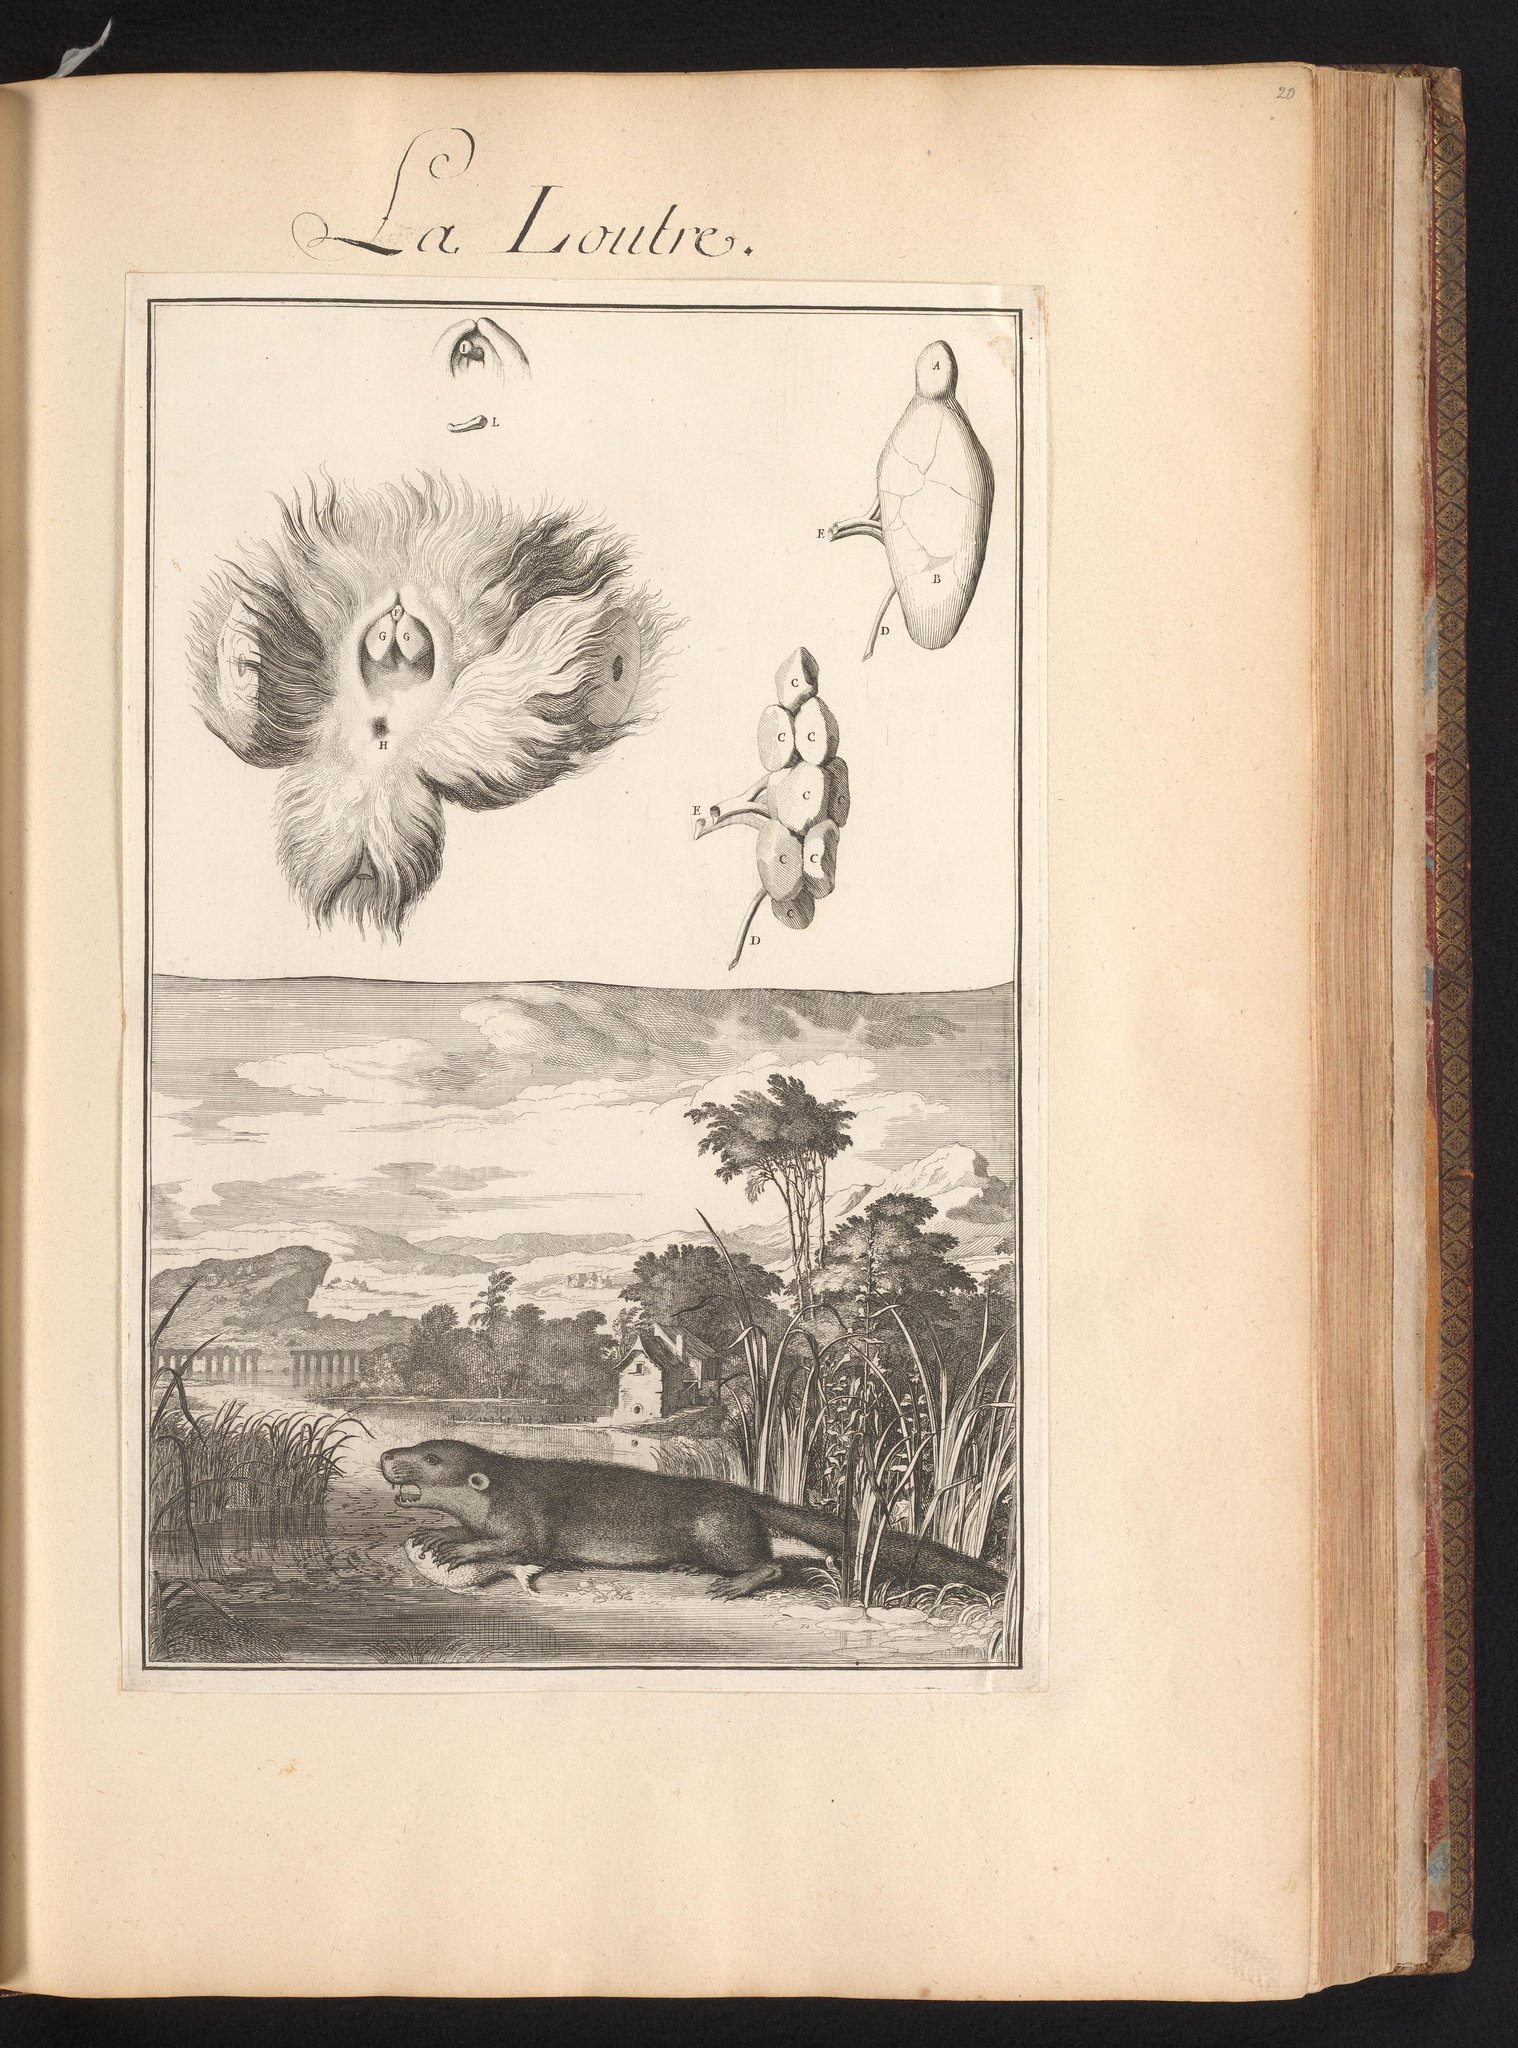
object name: print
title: Otter (lutrinae) met vis in een landschap met bovenaan op een blad de organen van het dier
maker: sébastien leclerc (i)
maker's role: print maker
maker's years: 1637-1714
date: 1671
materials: ink, paper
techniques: engraving, etching, pen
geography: paris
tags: dissection, beasts of prey, predatory animals: otter (+ anatomy of animals), beasts of prey, predatory animals: otter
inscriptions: inscription: ‘La Loutre.’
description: Prent uit: Perrault, Claude. Mémoires pour servir à l'histoire naturelle des animaux. Parijs: Imprimerie Royale, 1671.